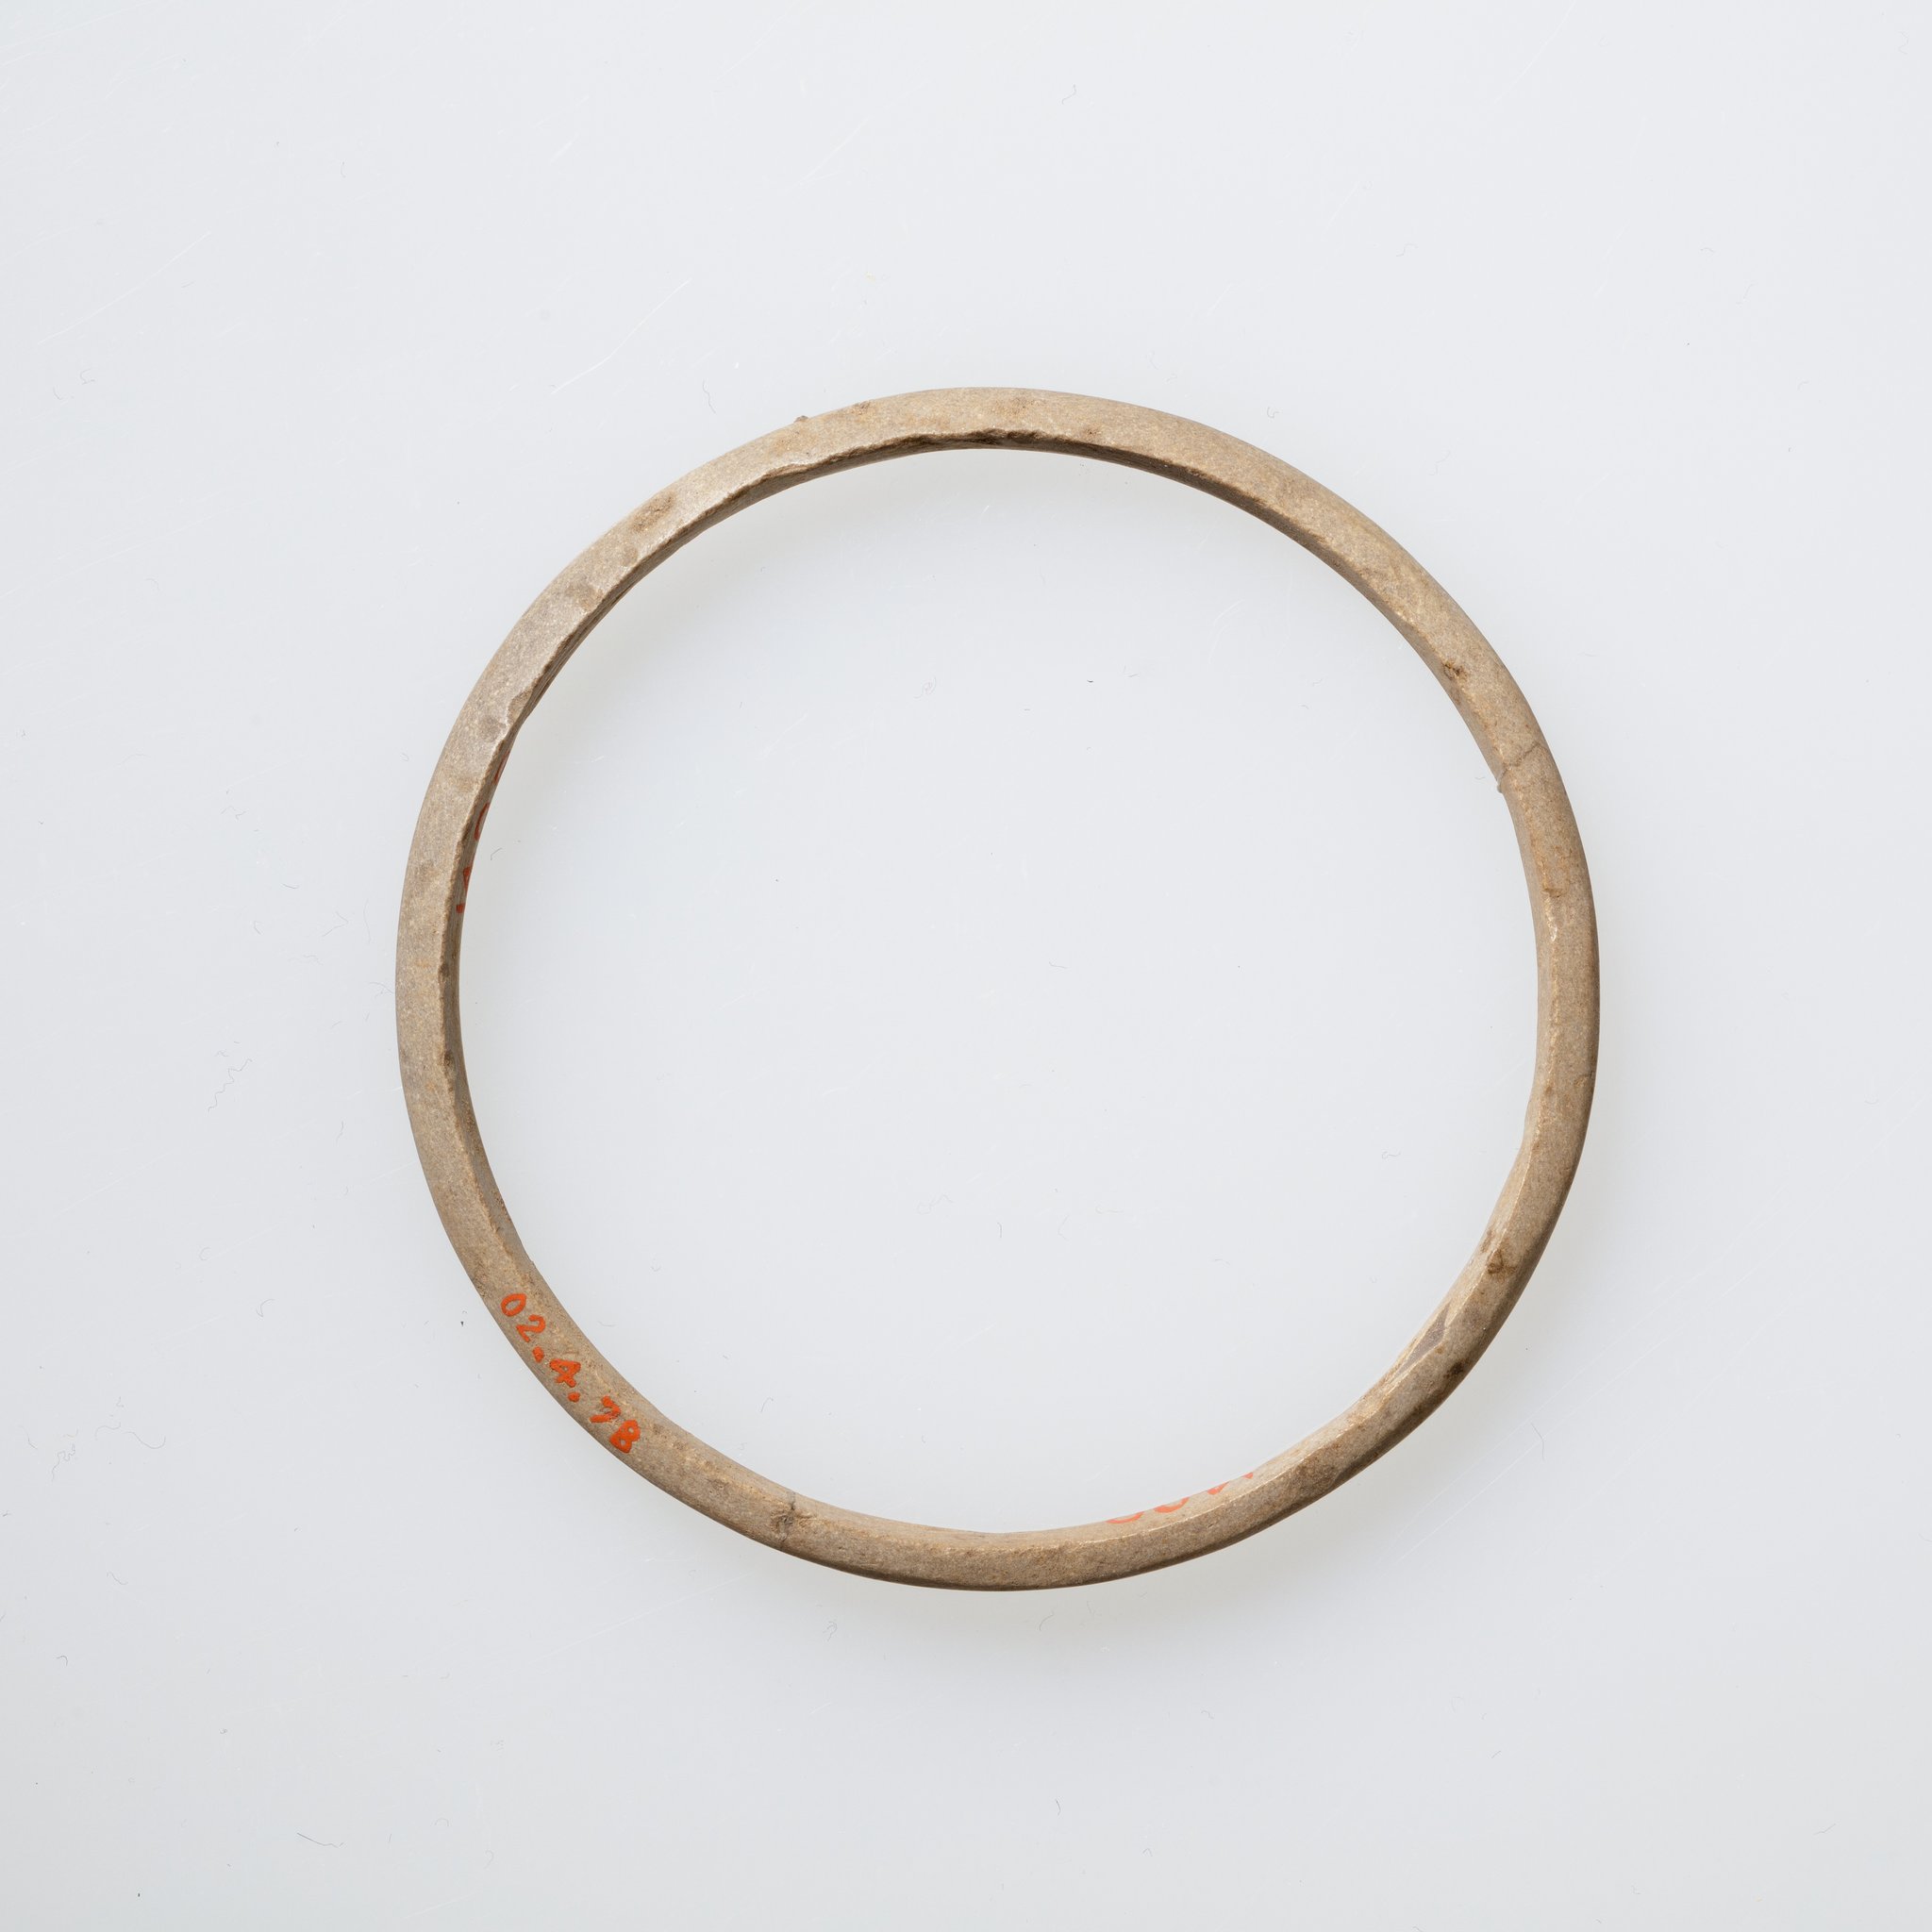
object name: bracelet bangle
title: Bracelet (Bangle)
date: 3100-2649 BCE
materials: stone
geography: egypt